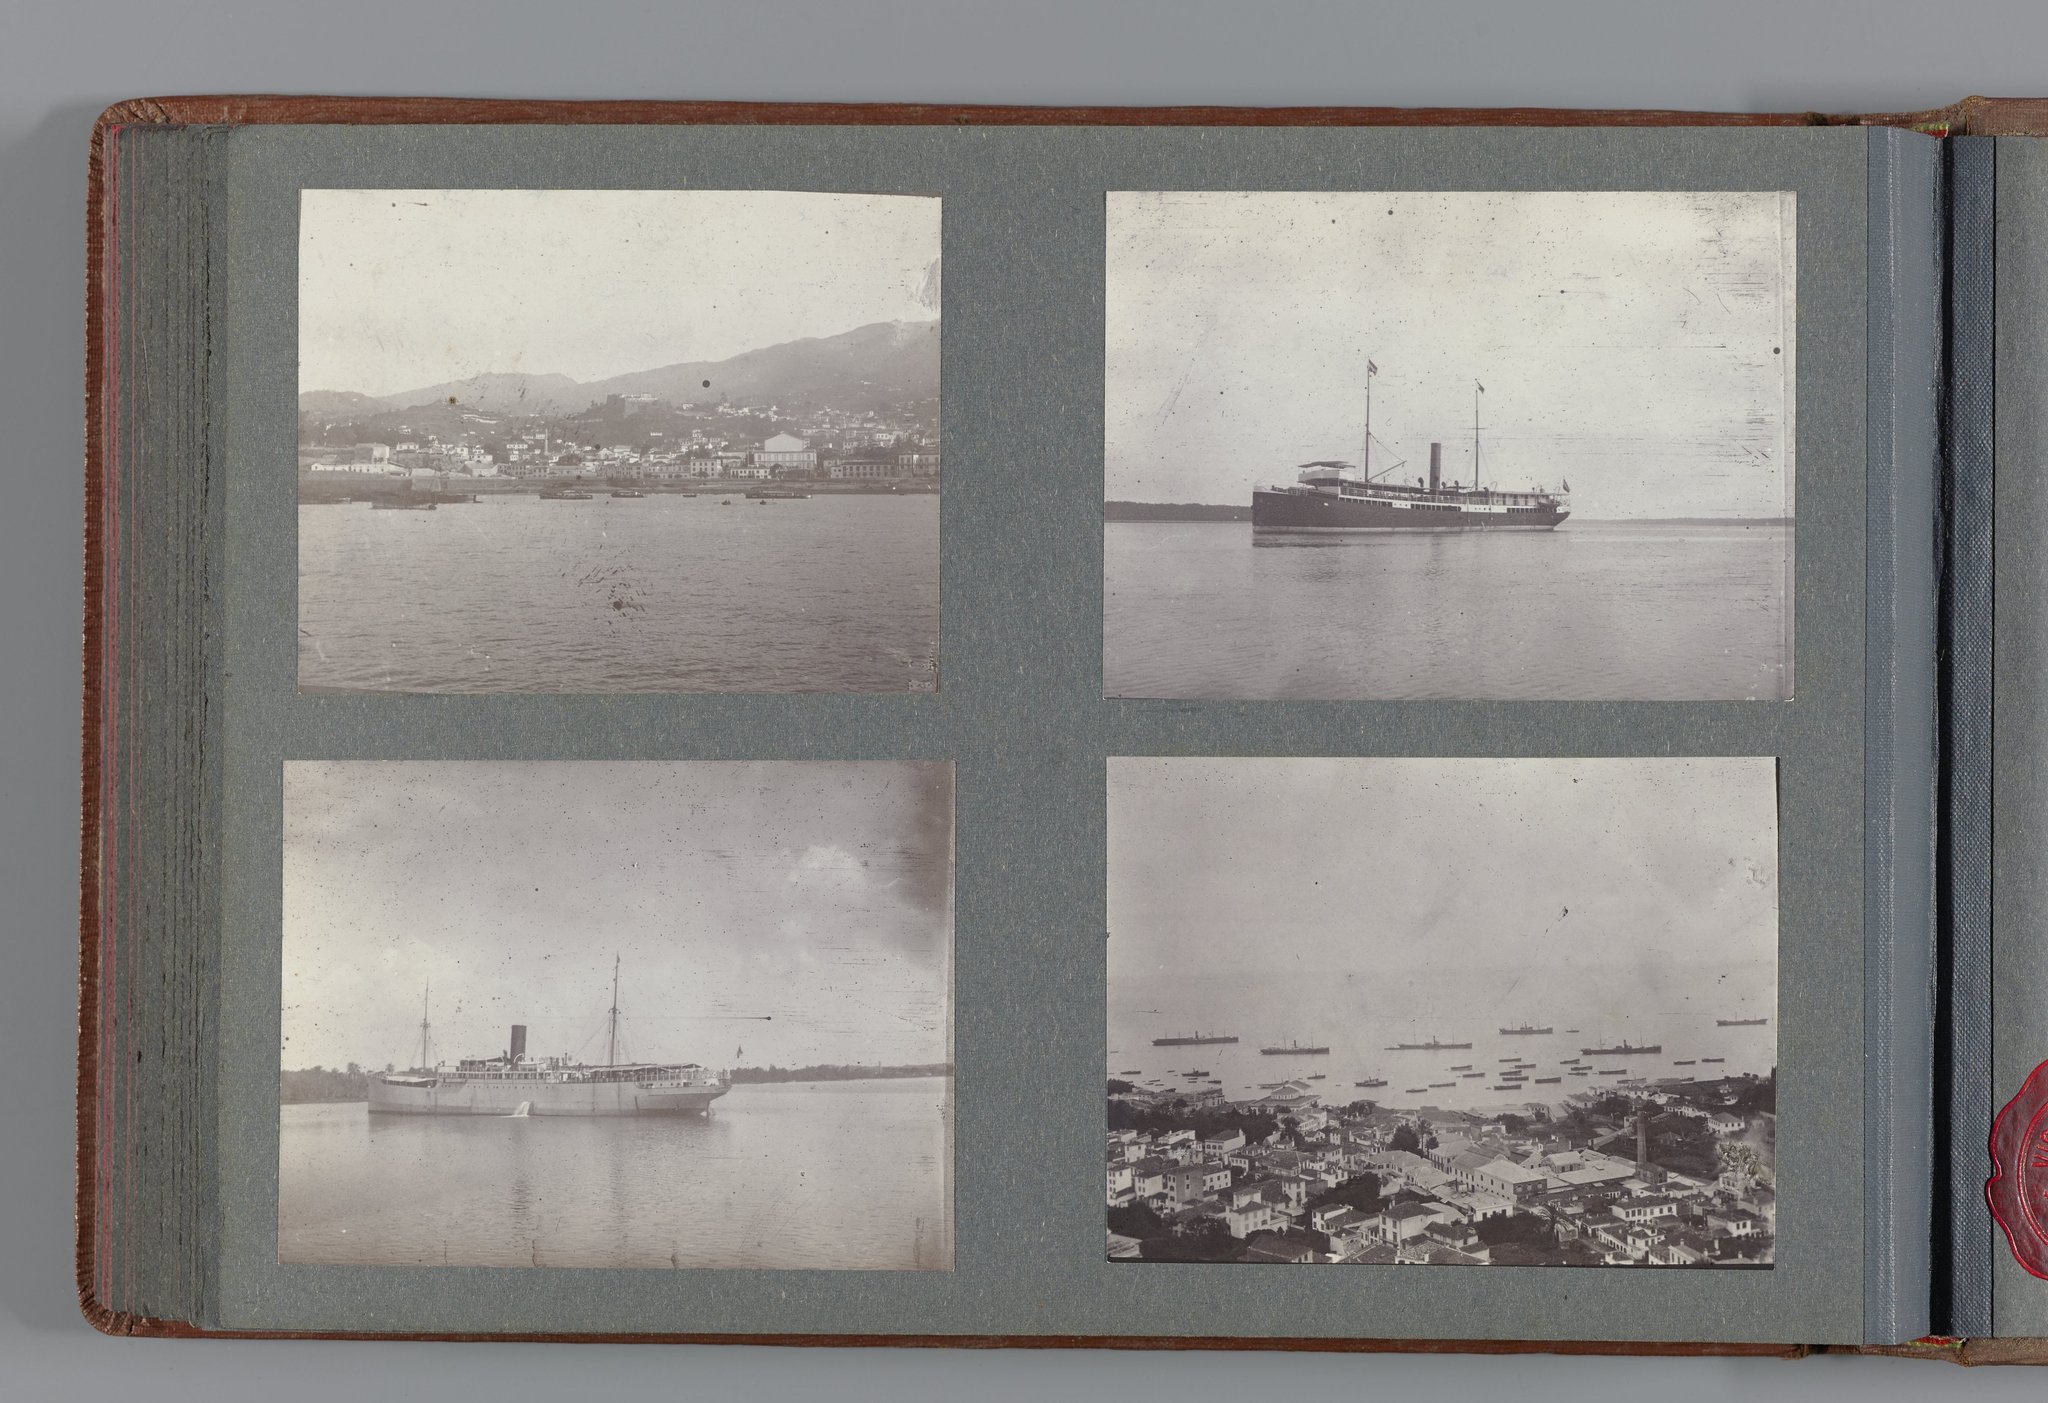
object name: photograph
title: Passagiersschip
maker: Anonymous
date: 1905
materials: cardboard, paper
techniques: photography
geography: paramaribo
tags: suriname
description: Passagiersschip. Onderdeel van fotoalbum 'Suriname'.